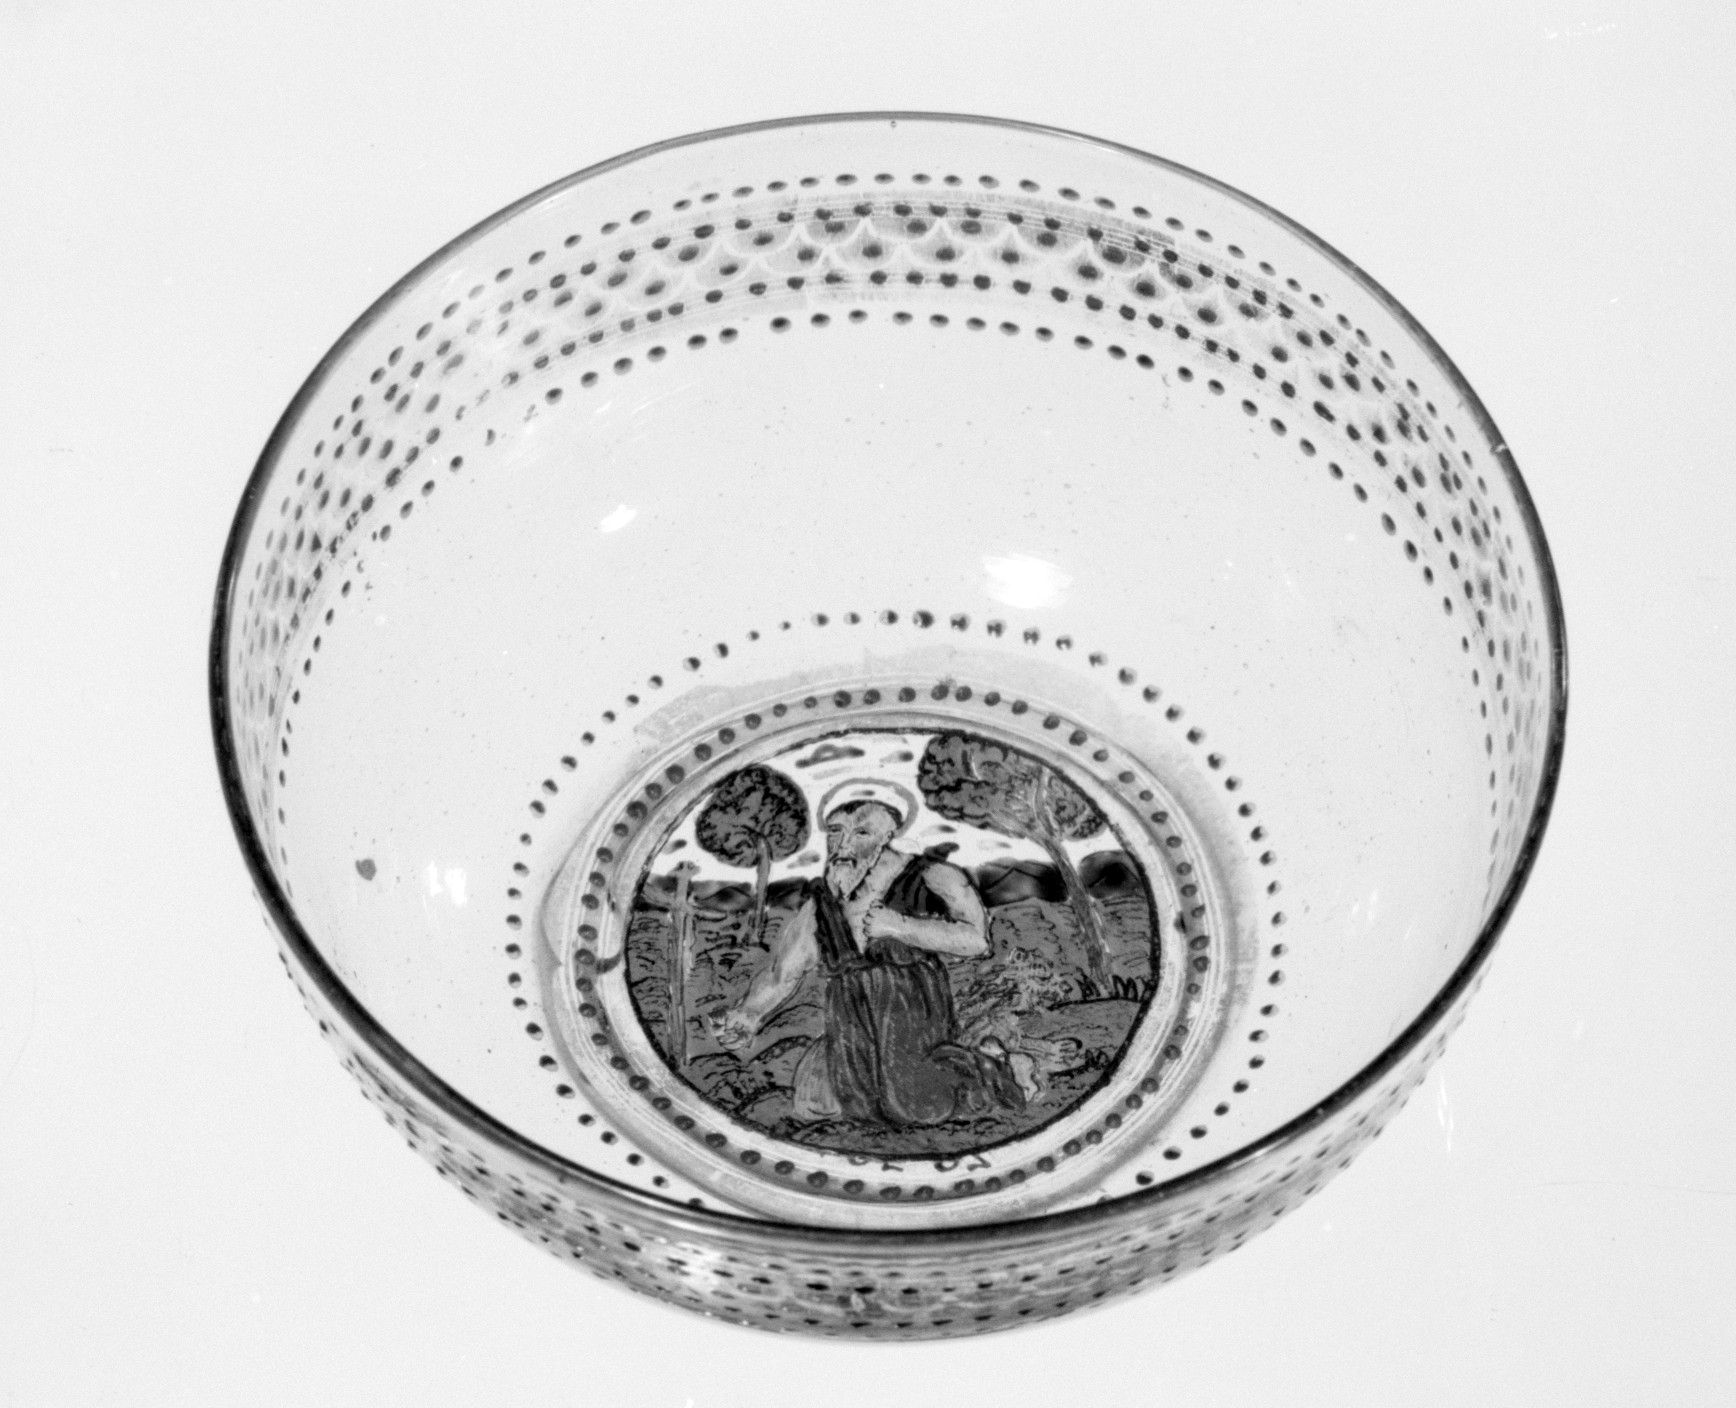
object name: bowl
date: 1501-1533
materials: gilt, glass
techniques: enamel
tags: men,trees